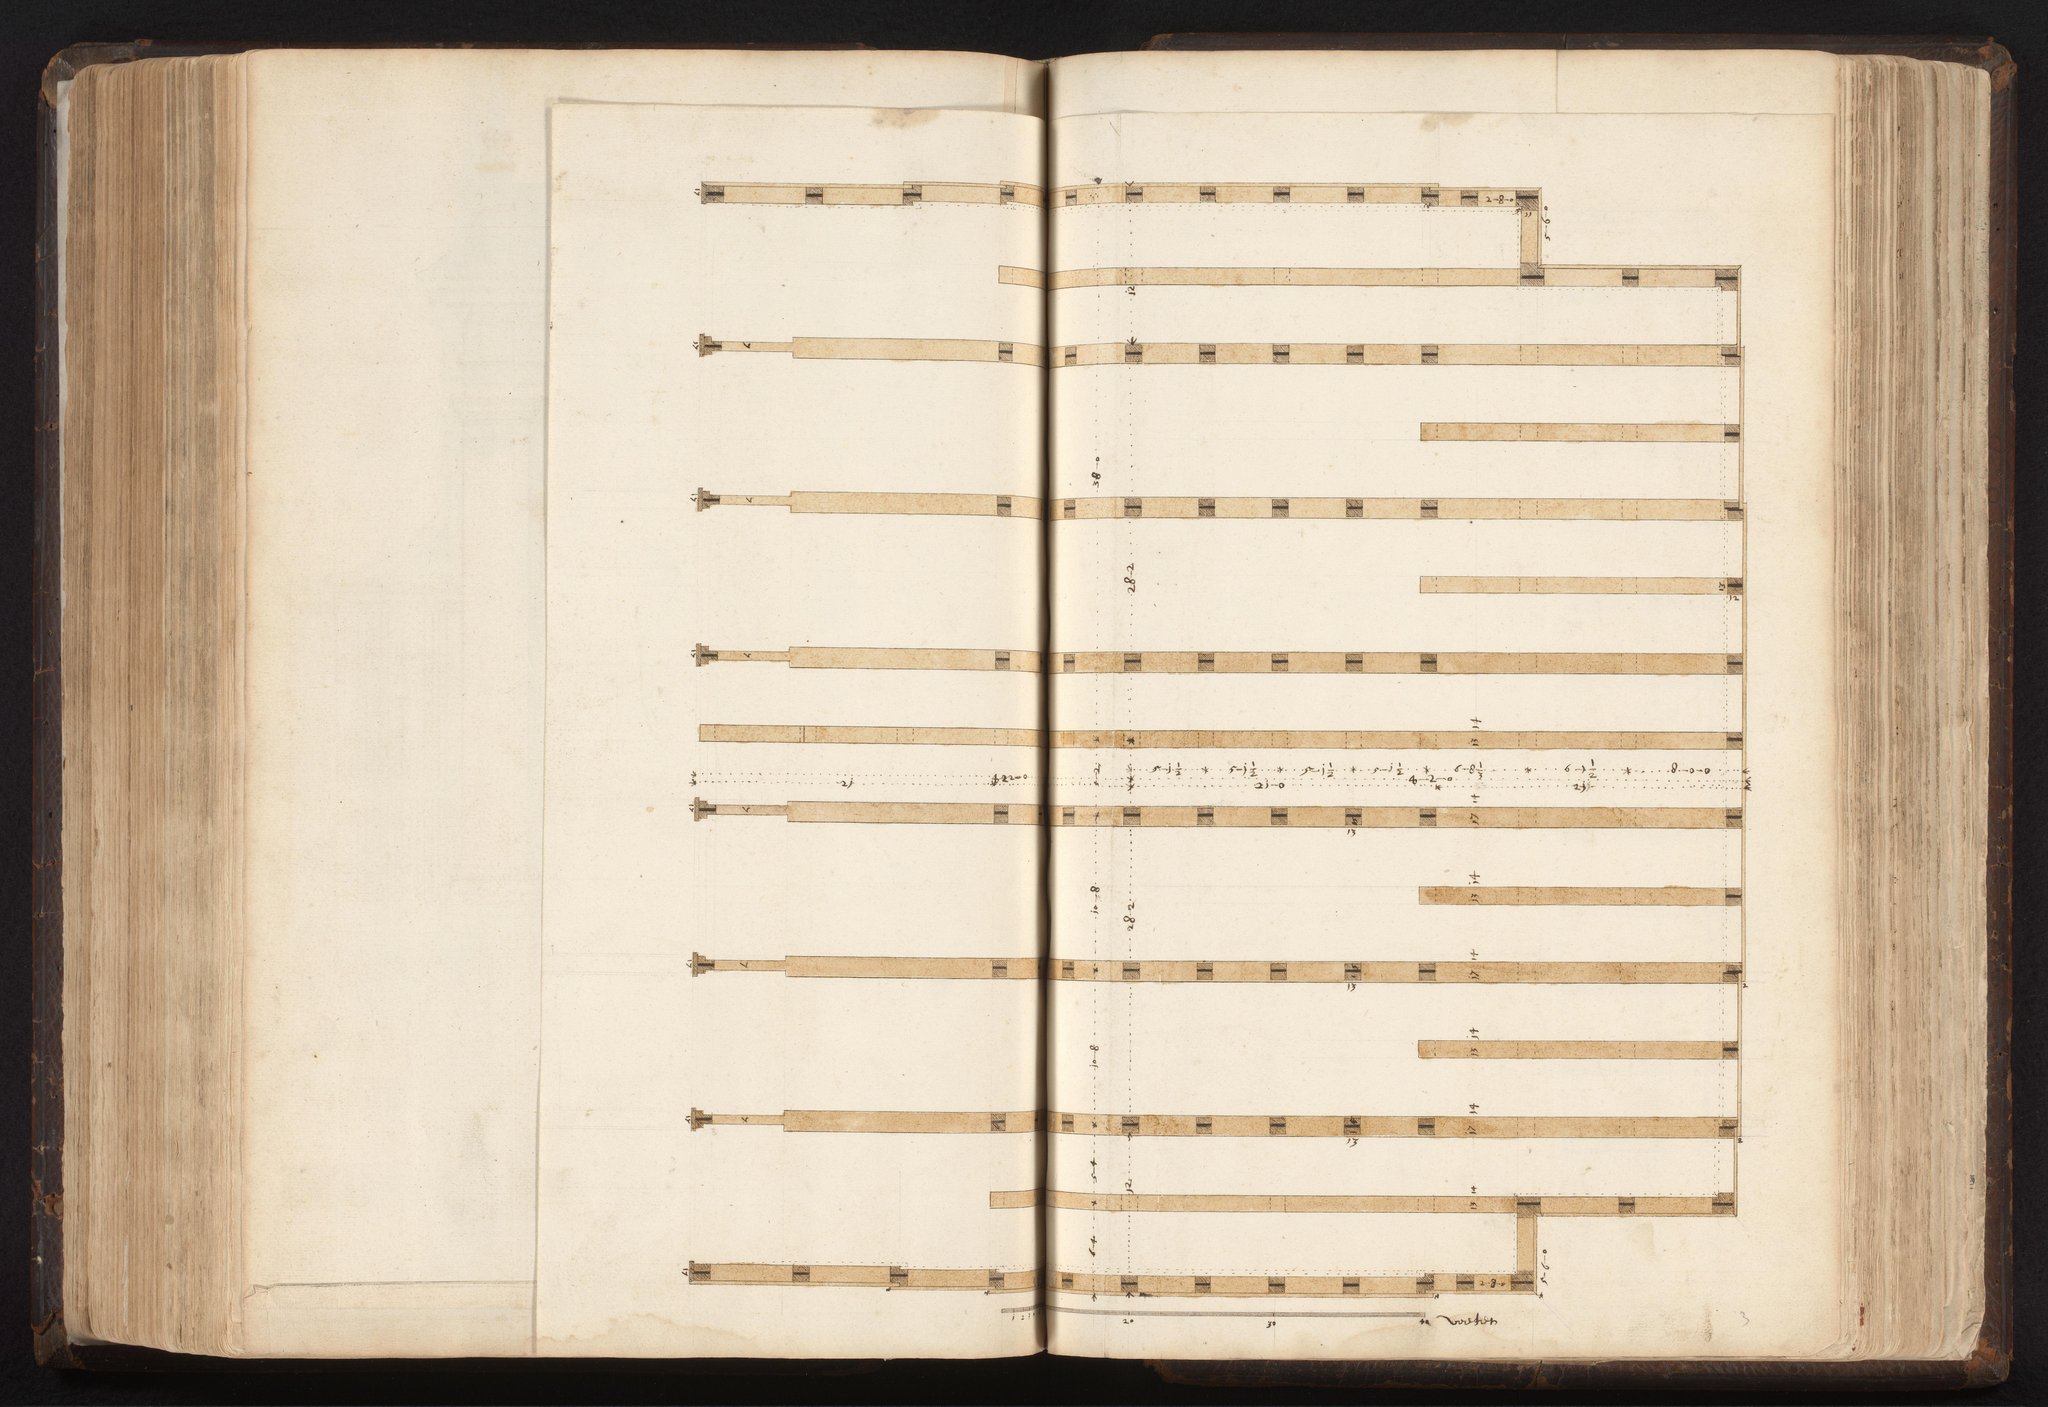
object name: album leaf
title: Plattegrond van de fundering van de Blokhuizen in de Amstel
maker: Anonymous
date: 1650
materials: ink, paper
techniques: brush, pen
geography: amsterdam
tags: building activities, plan ~ architecture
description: Met afmetingen en onderaan een schaalaanduiding. Tekening maakt deel uit van een album.